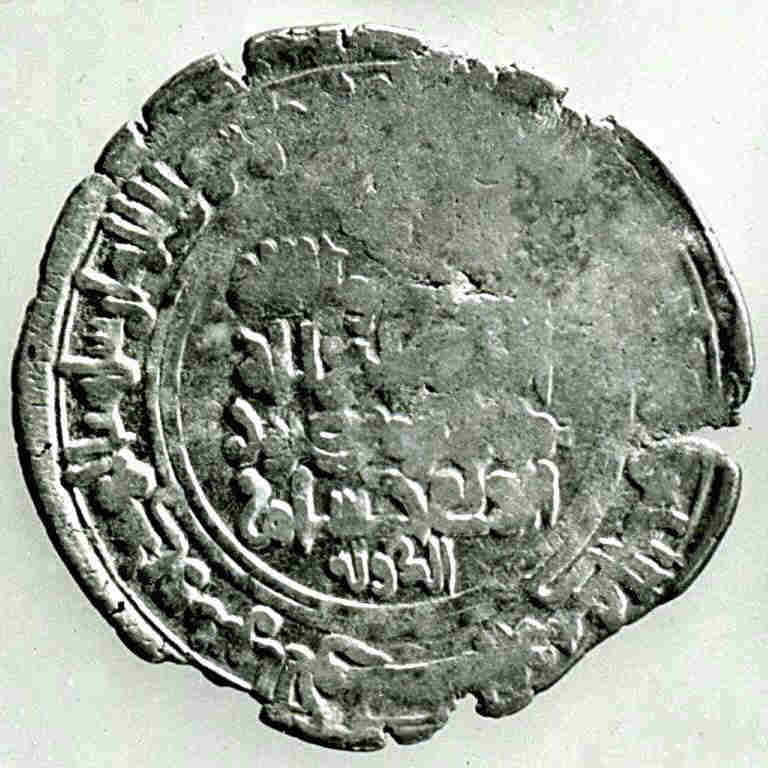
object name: coin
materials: silver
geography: iran